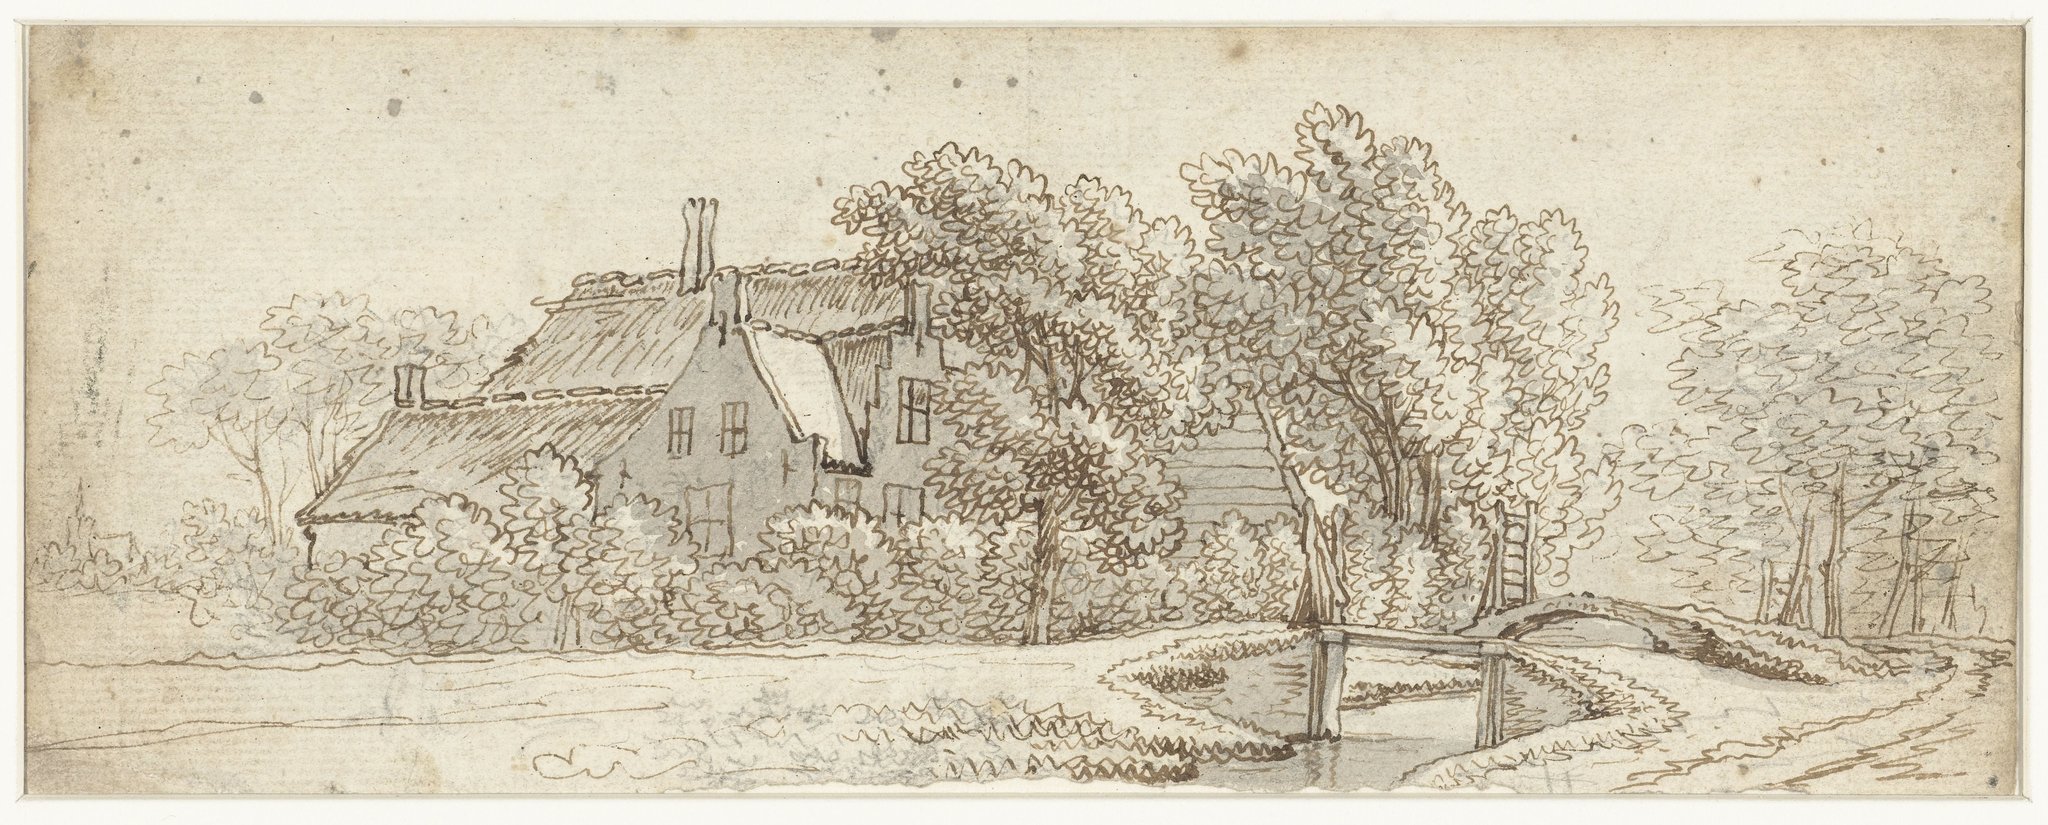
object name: drawing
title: Boerderij, door bruggen met een weg verbonden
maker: Anonymous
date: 1700-1800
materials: ink, paper, pencil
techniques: brush, pen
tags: farm or solitary house in landscape